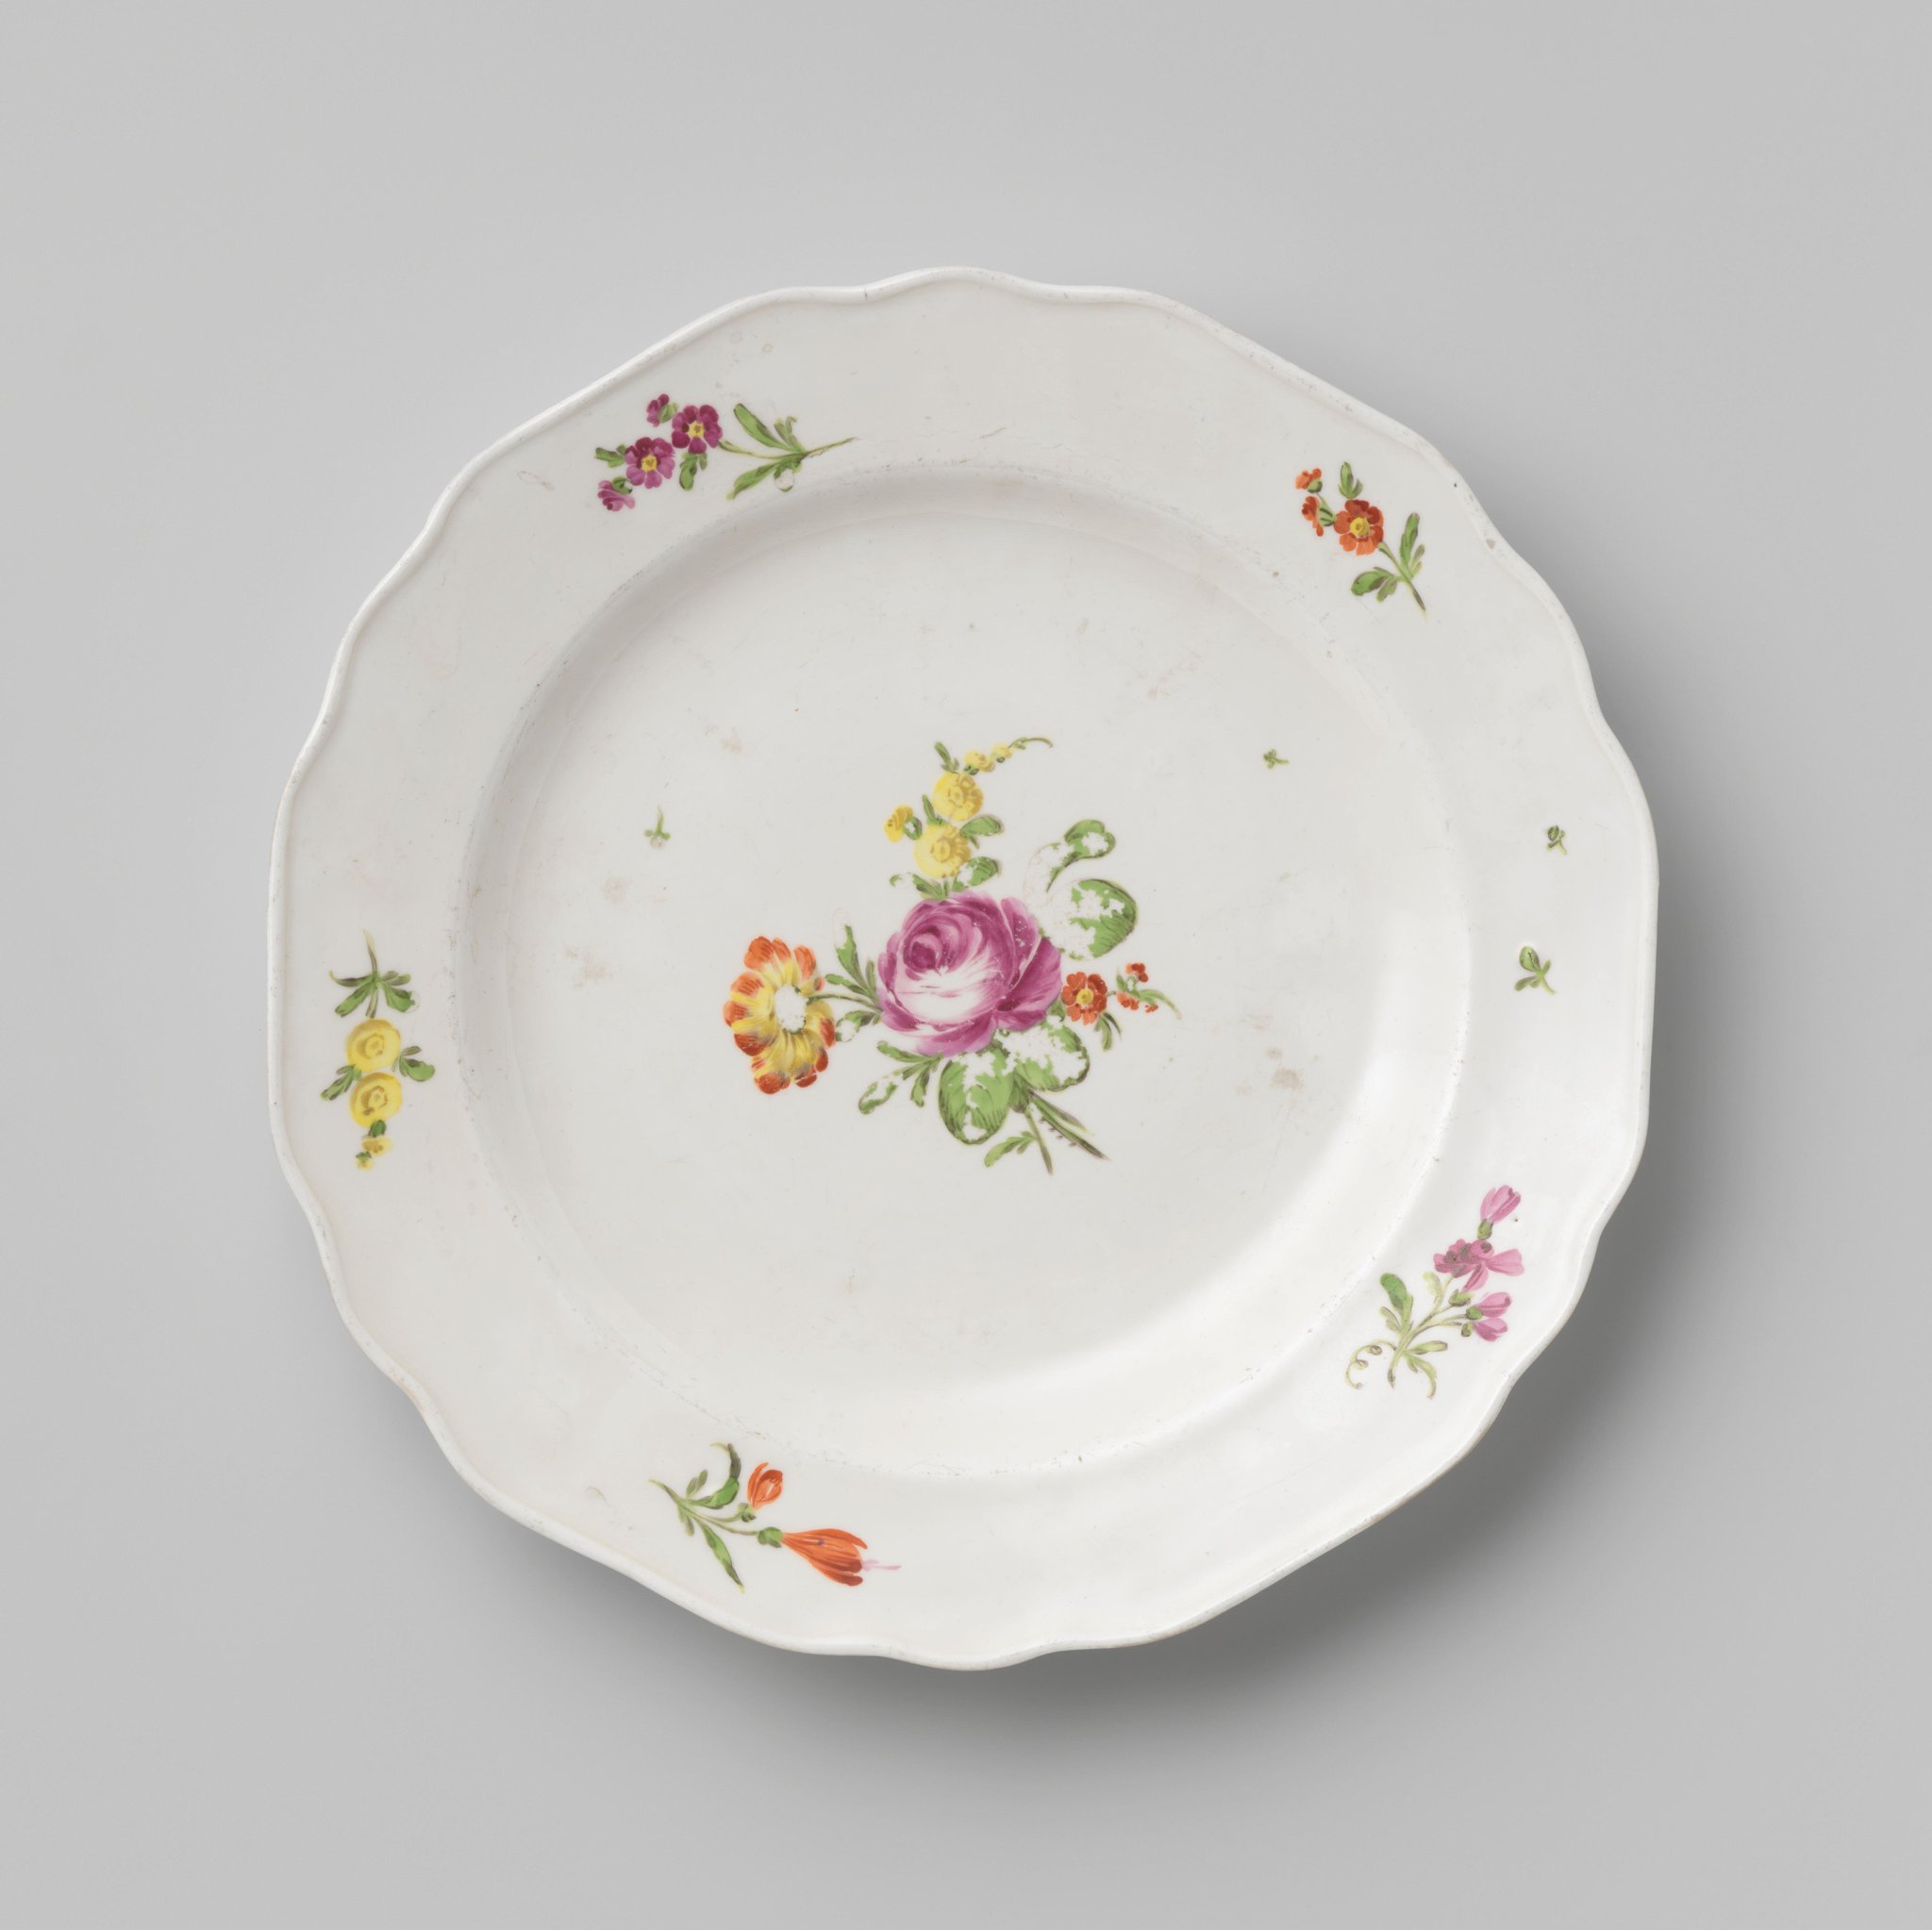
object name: plate dish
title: Plate with a bouquet and flower sprays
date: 1800-1849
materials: glaze, paint, porcelain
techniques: firing, forming, turning, vitrification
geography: vienna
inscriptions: mark: ‘schild/ P[?] / 40/ / 89/ I’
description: Bord van porselein met een gelobde rand, beschilderd op het glazuur in rood, roze, groen en geel. Op het plat een boeket van verschillende bloemen (o.a. pioenroos) omgeven door losse takjes en op de rand vijf bloemtakken. Gemerkt op de onderzijde met het schild, de letter P [?], de nummers 40 en 89 en I. Op enkele plekken heeft het email losgelaten.